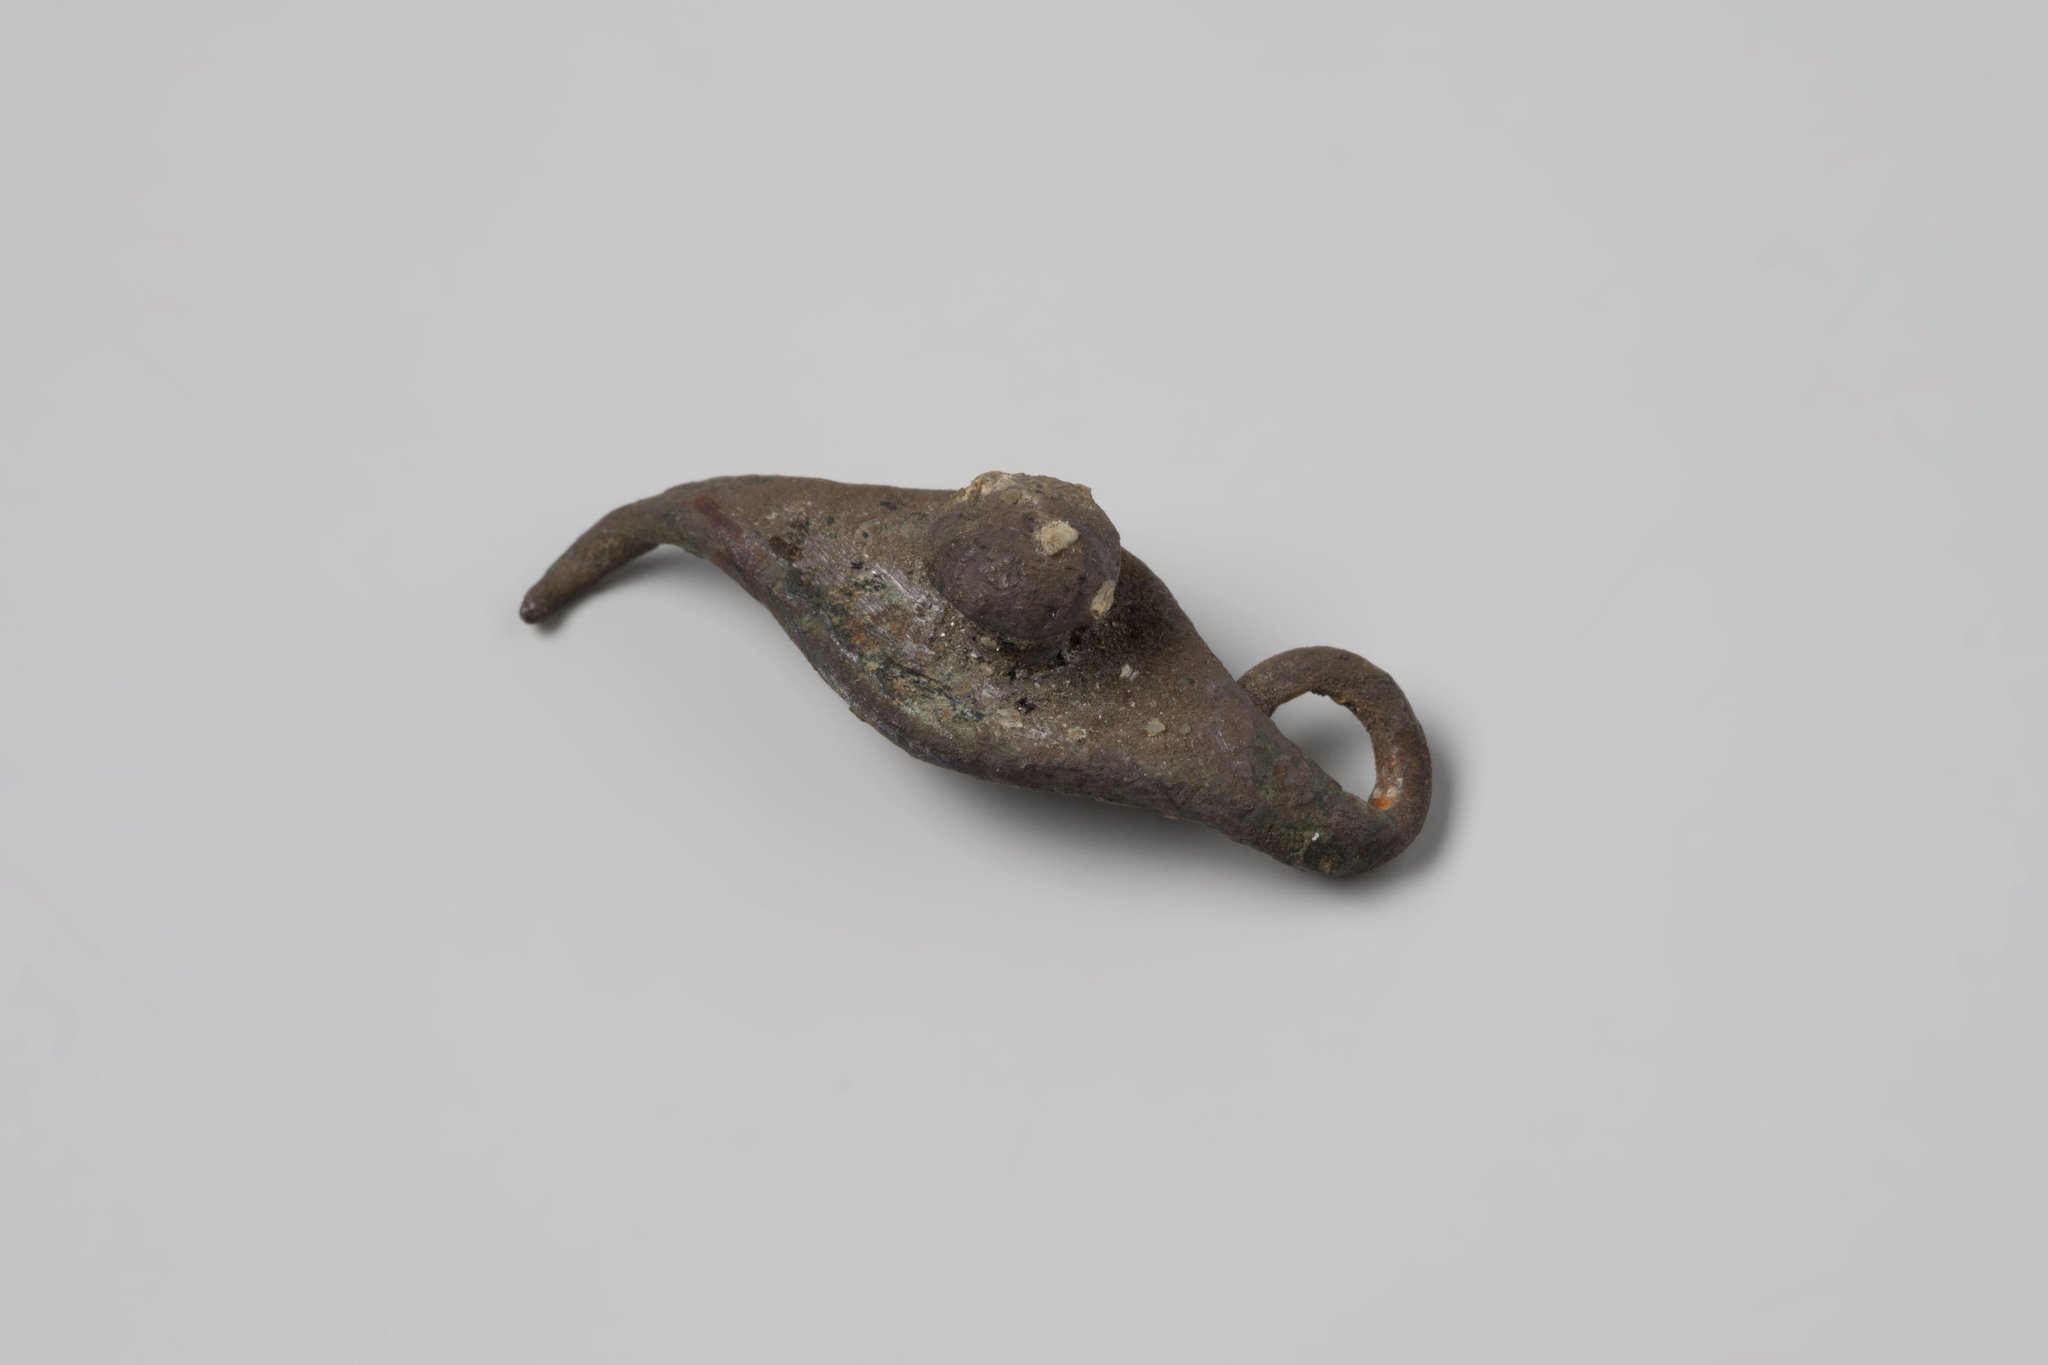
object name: beslag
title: Decoratief beslag uit het wrak van de Oost-Indiëvaarder Hollandia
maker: Anonymous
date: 1700-1743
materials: silver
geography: netherlands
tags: verenigde oostindische compagnie, hollandia (schip), annet